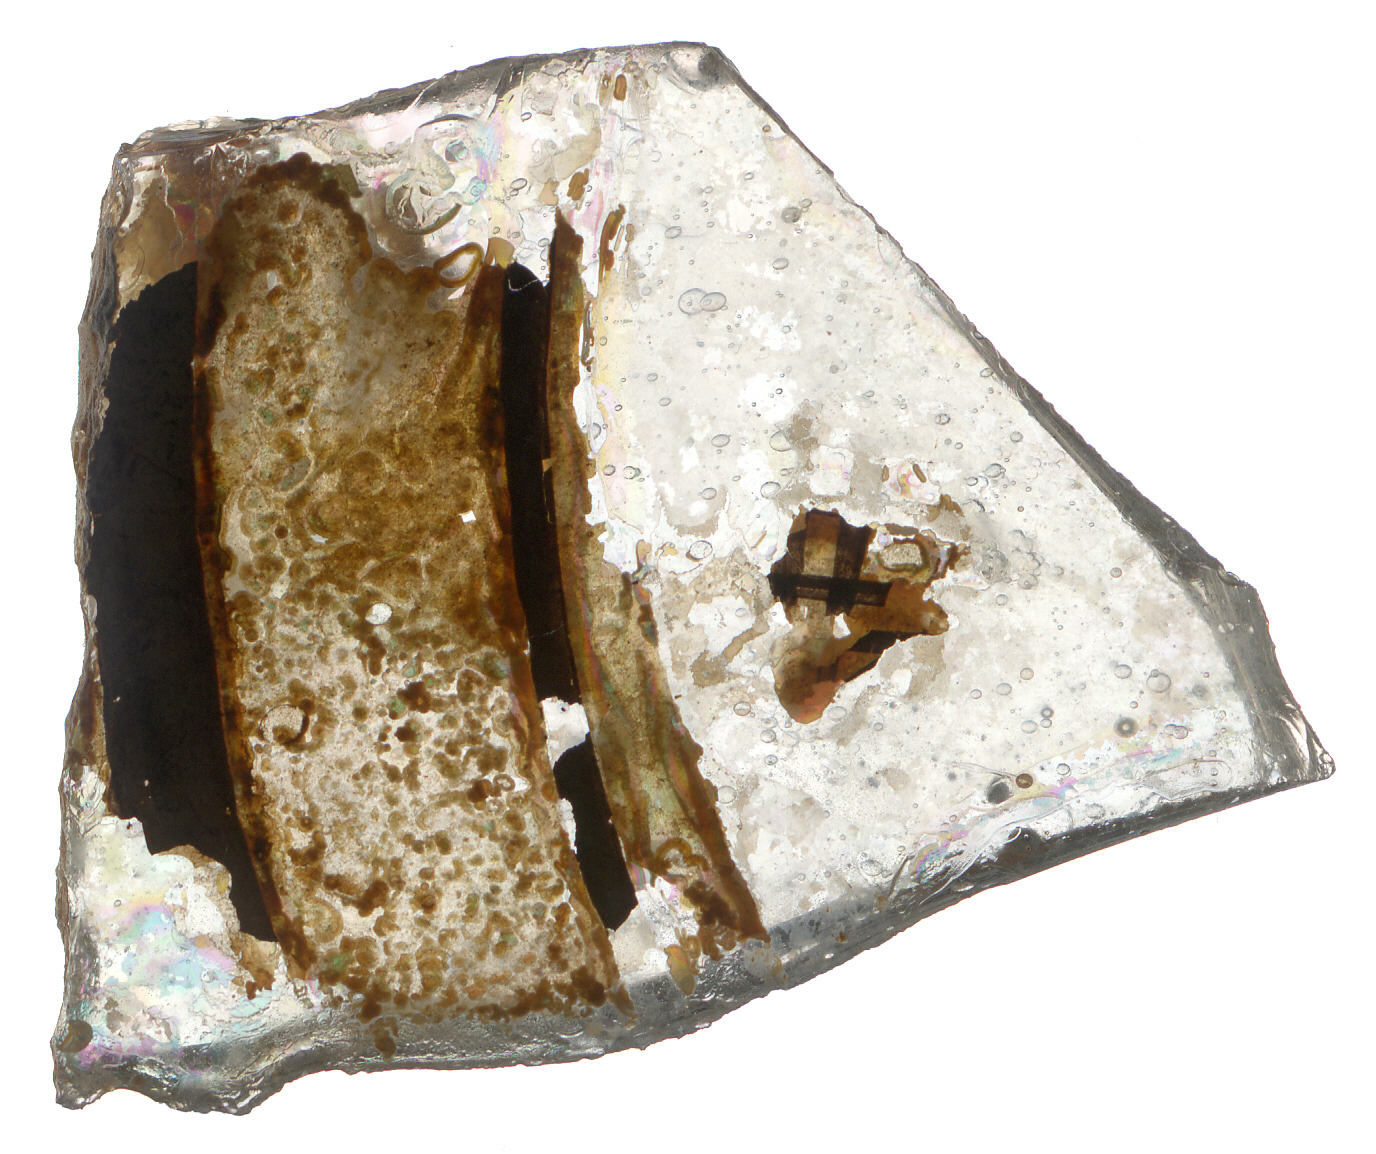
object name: fragment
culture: crusader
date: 1201-1300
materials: glass